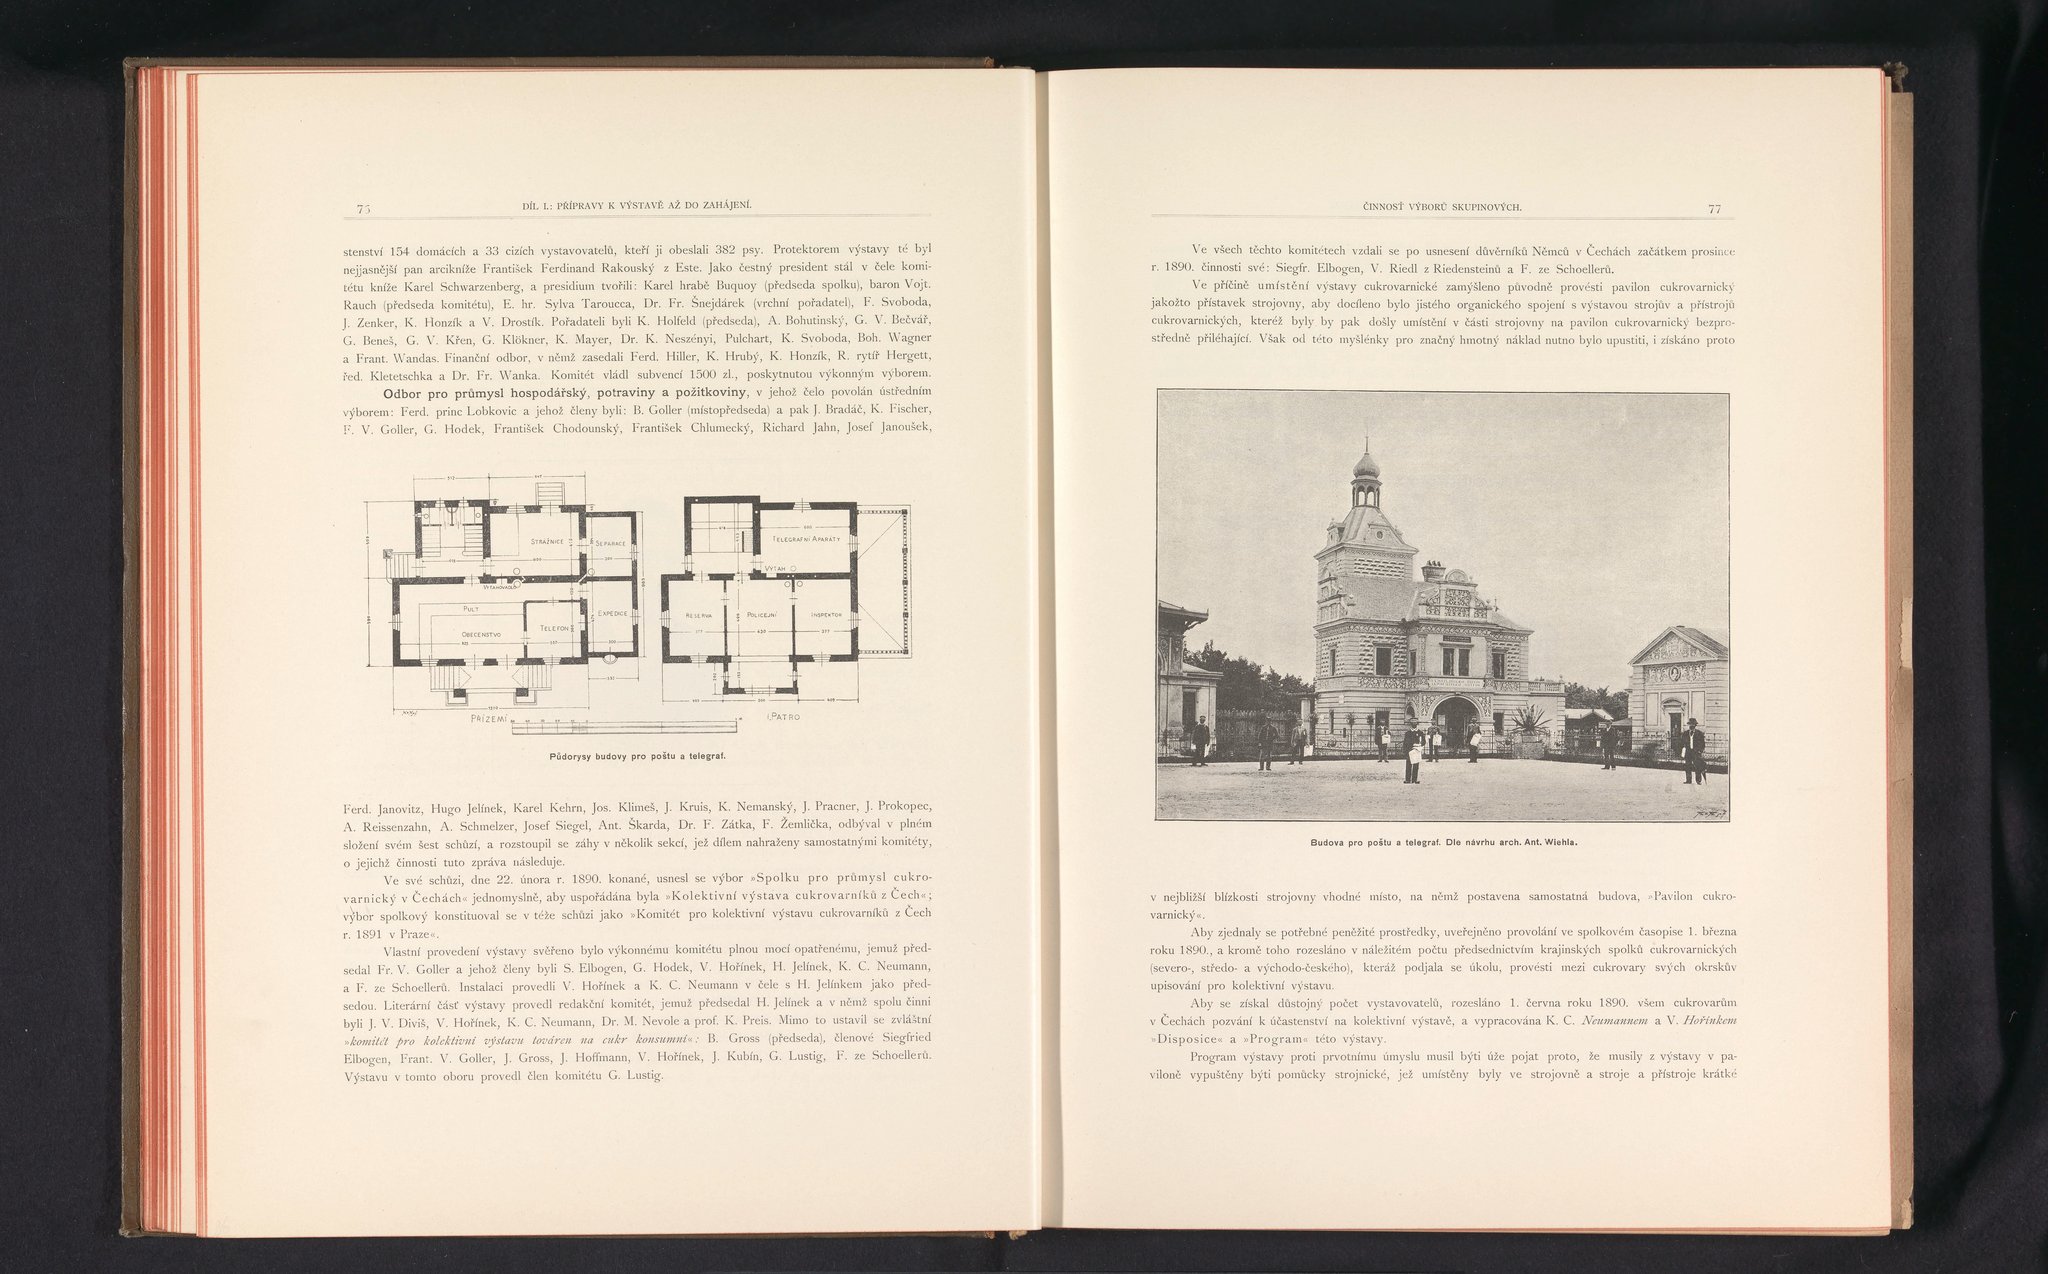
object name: page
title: Exterieur van een postkantoor te Praag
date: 1888-1893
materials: paper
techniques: autotype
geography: prague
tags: post-office, façade (of house or building)